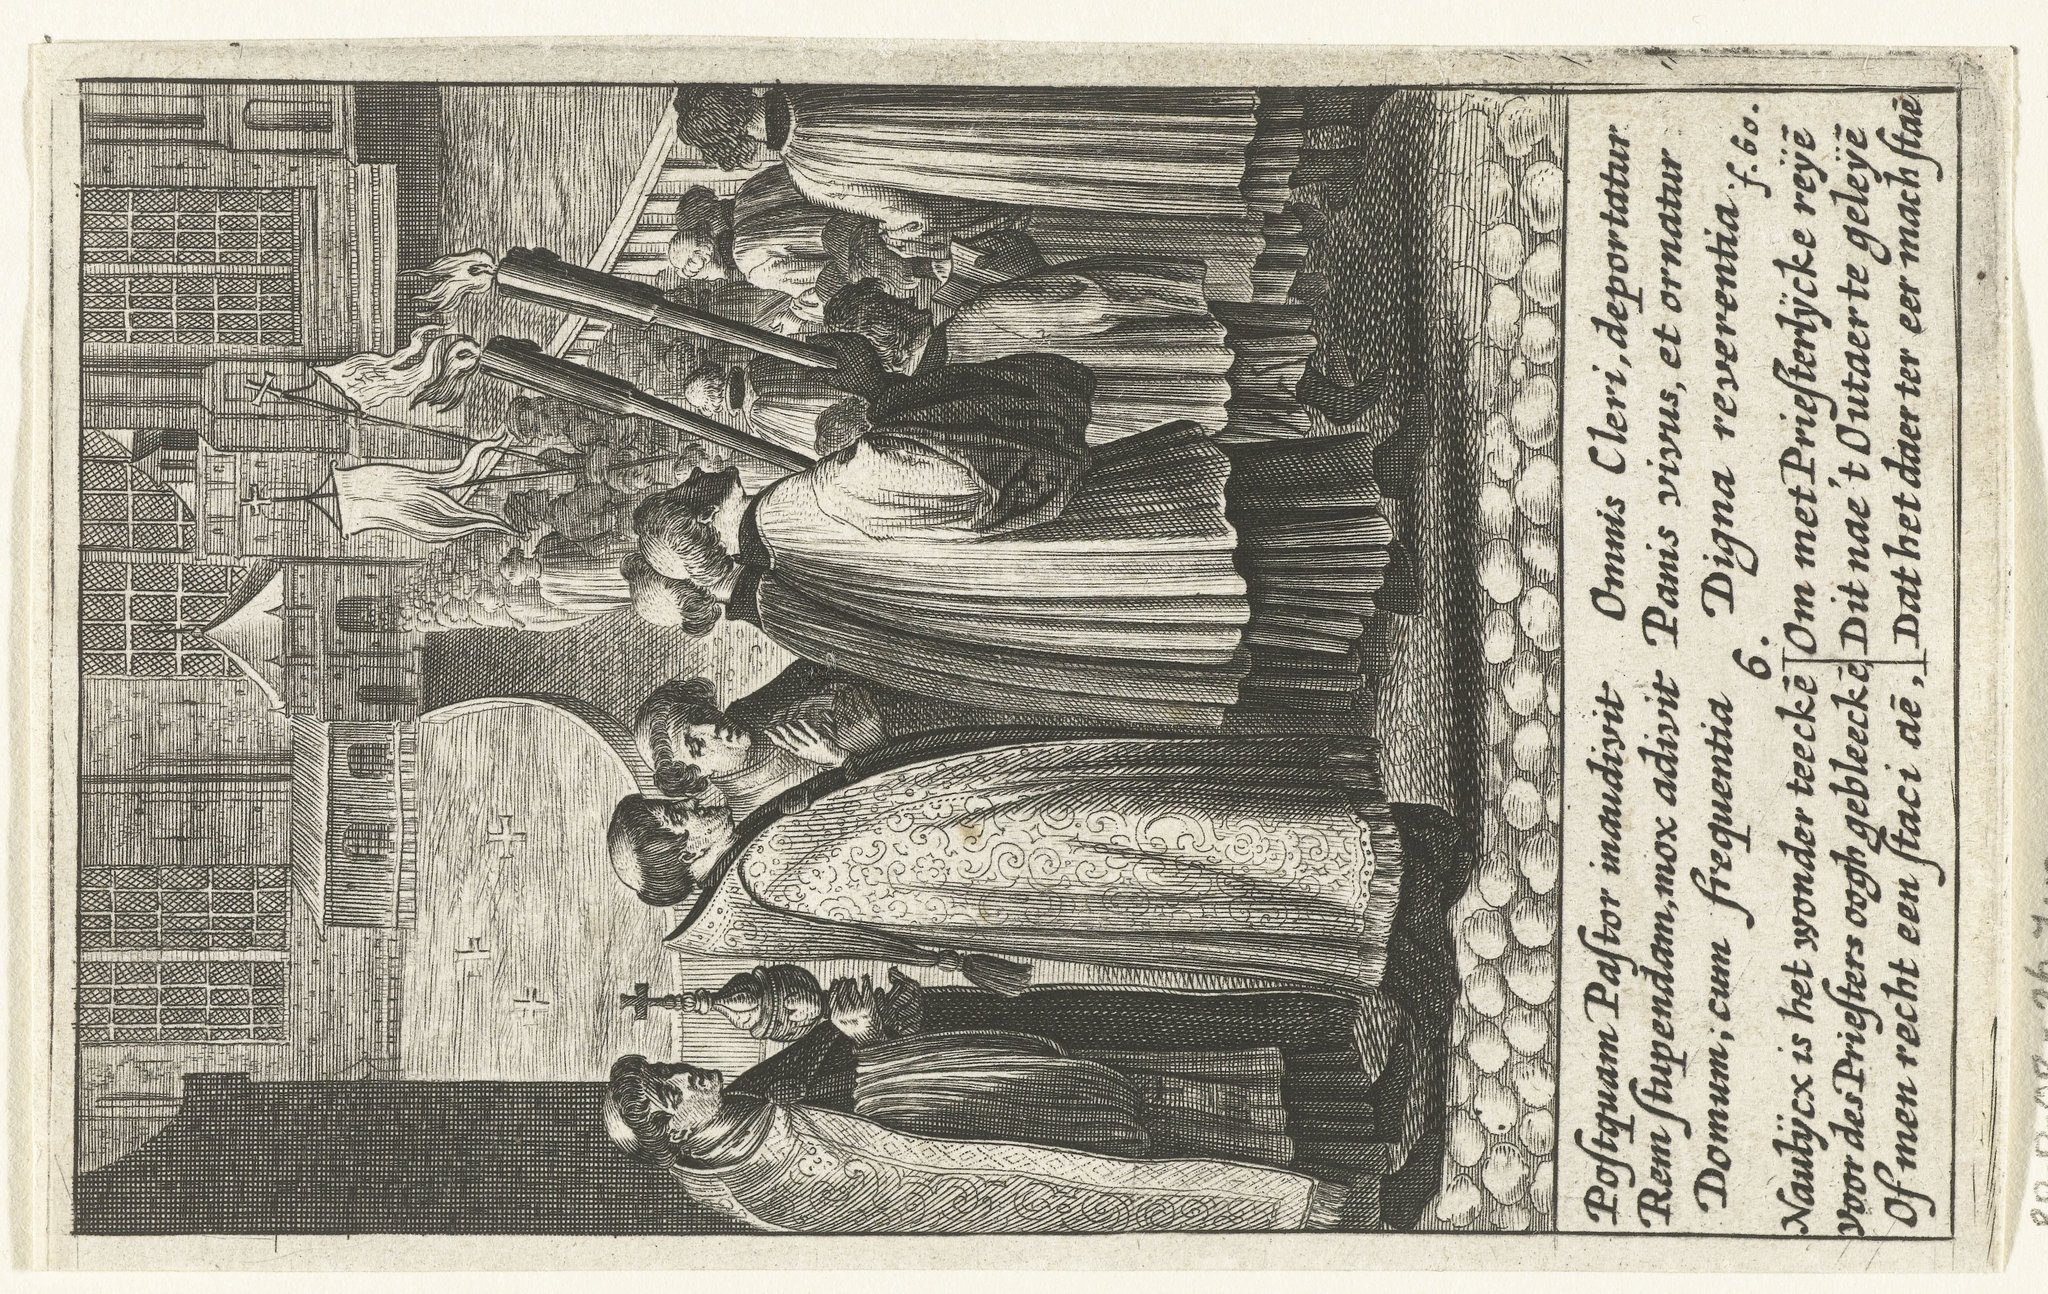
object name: print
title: Hostie wordt in processie naar de kerk gedragen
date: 1590-1633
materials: paper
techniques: engraving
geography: antwerp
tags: legends and miracles associated with the eucharist (or the host)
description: Prent uit: Leonardus Marius, Amstelredams eer ende opcomen, door de denckwaerdighe miraklen aldaer geschied aen ende door het H. Sacrament des Altaers Anno 1345, Antwerpen, Hendrick Aertssens, 1639, afb. 6